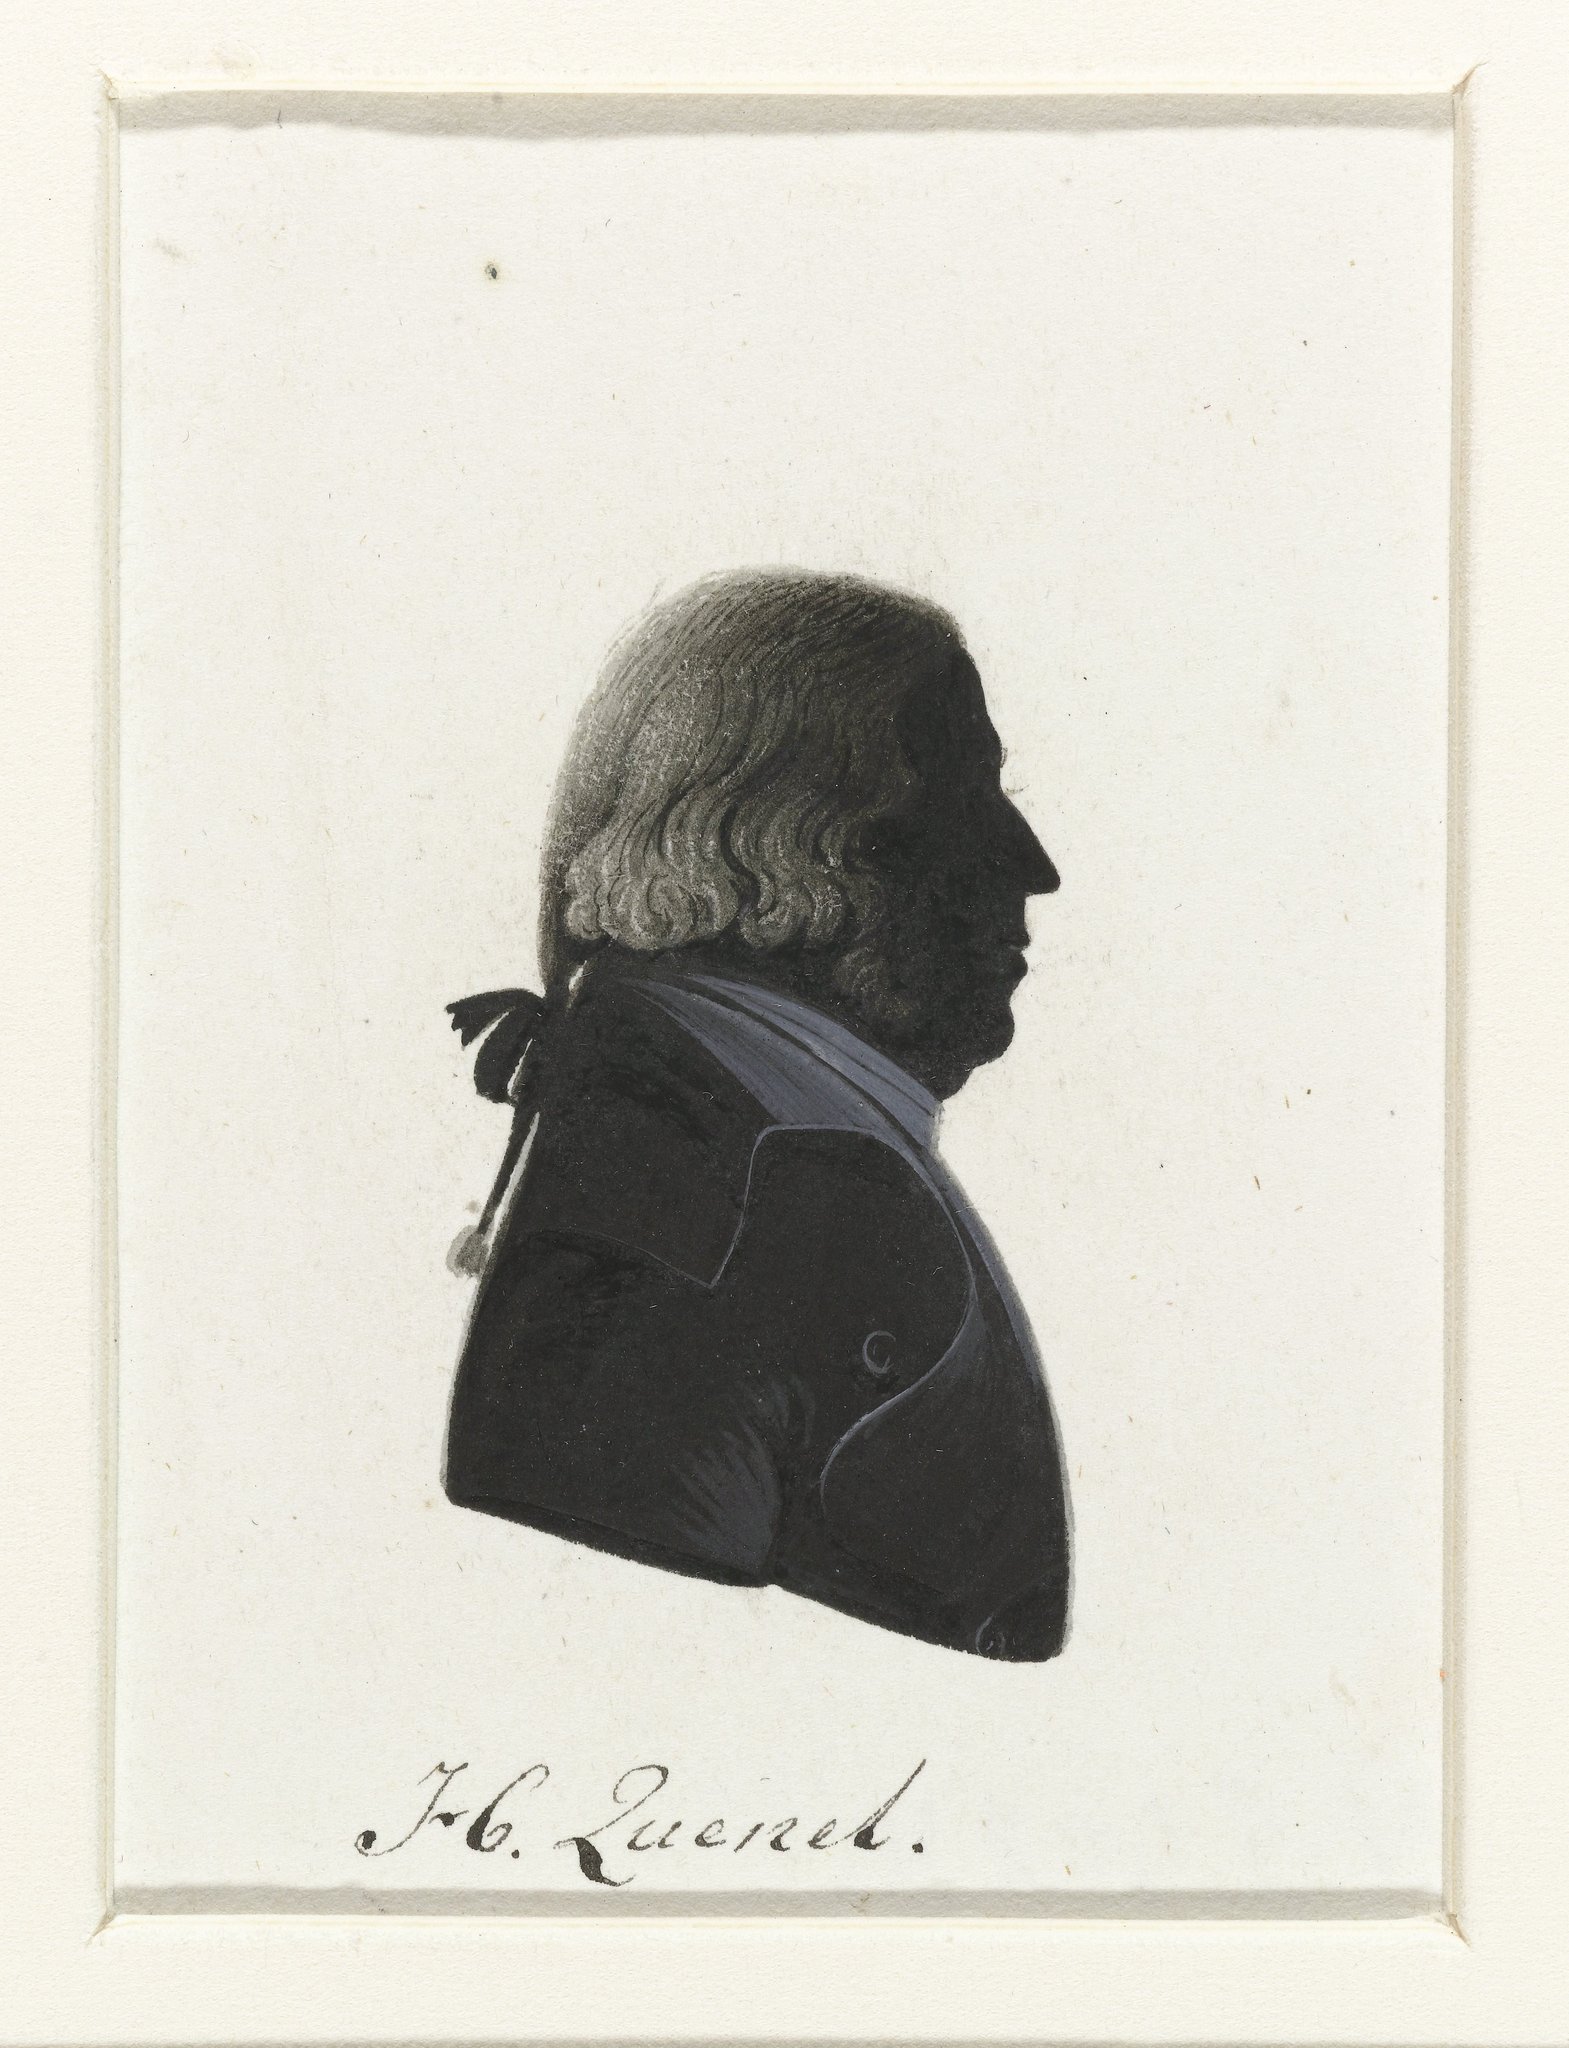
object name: silhouette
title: Representanten van de eerste Nationale Vergadering van de Bataafse Republiek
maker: hausdorff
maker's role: draughtsman, print maker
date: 1796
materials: ink, paper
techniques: drawing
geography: netherlands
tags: historical persons (+ profile portrait), the hague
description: Silhouettes of members of the National Assembly. India ink on paper, 1796. Early in 1795 Stadholder William V fled to England. In the Republic a new regime was installed. A year later, the country held its first general election. Every Dutch man over the age of twenty and not on poor relief was entitled to vote for a candidate to the National Assembly, the parliament of the Batavian Republic, as the country was known between 1795 and 1806. The 126 representatives who sat in the assembly were drawn from the educated, progressive elite of Dutch society.